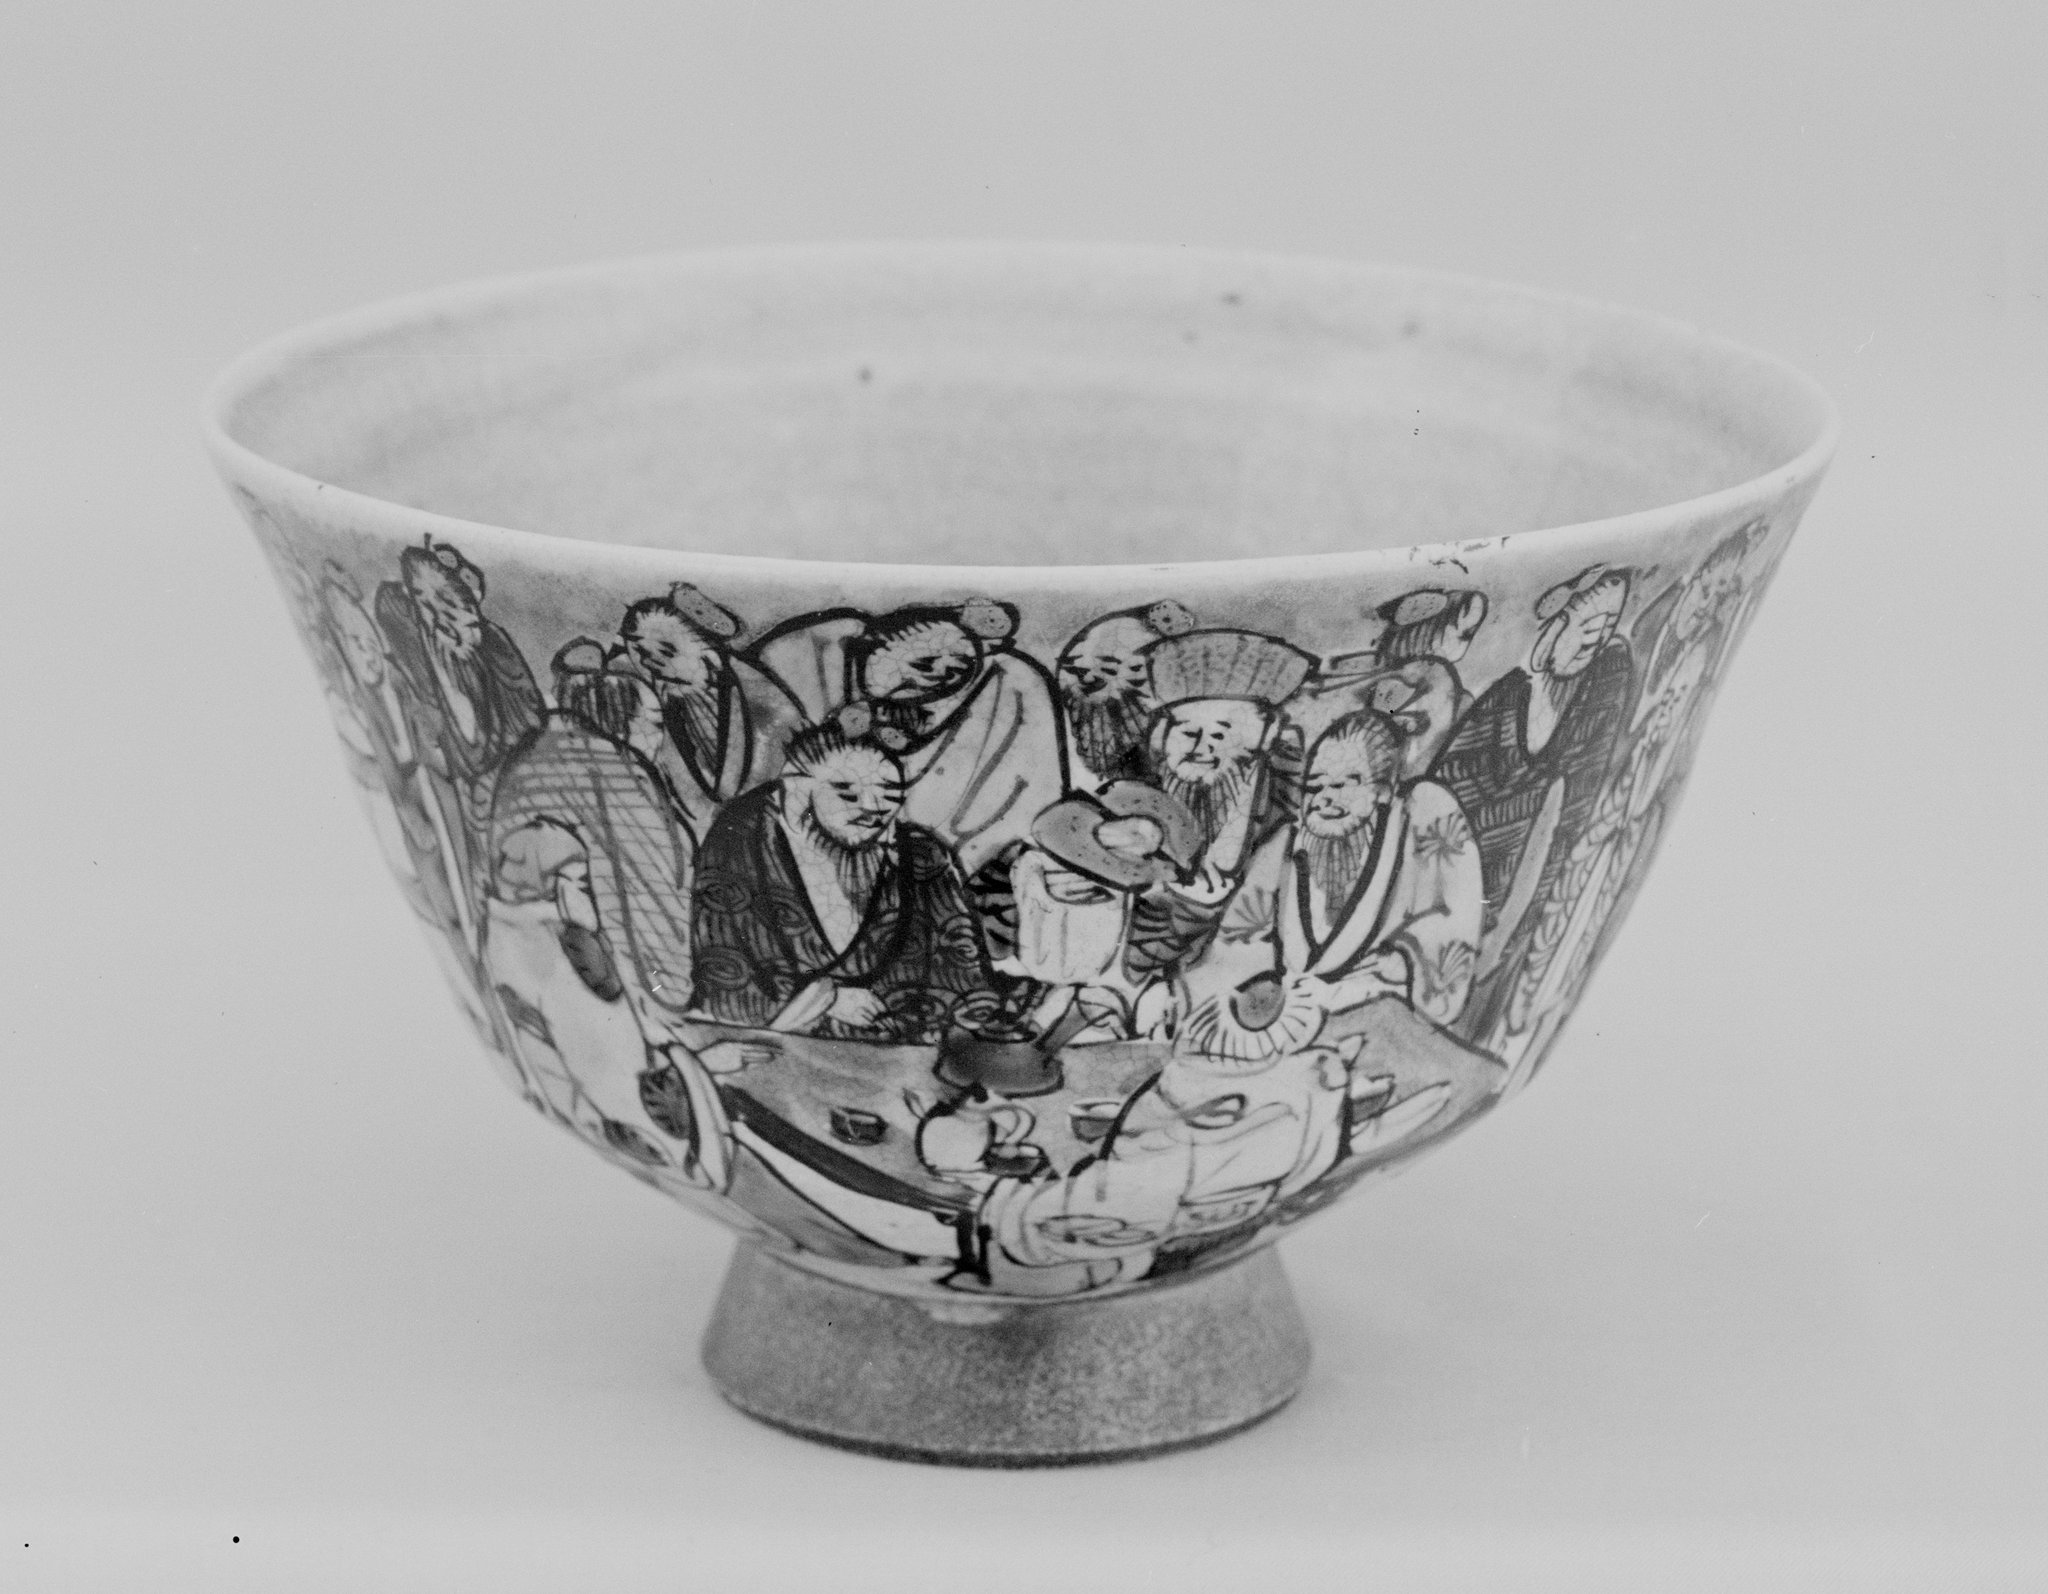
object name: bowl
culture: japanese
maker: nonomura ninsei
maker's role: artist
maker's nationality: japanese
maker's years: 1646-1694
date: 1801-1900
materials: clay, enamel, glaze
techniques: polychrome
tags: men